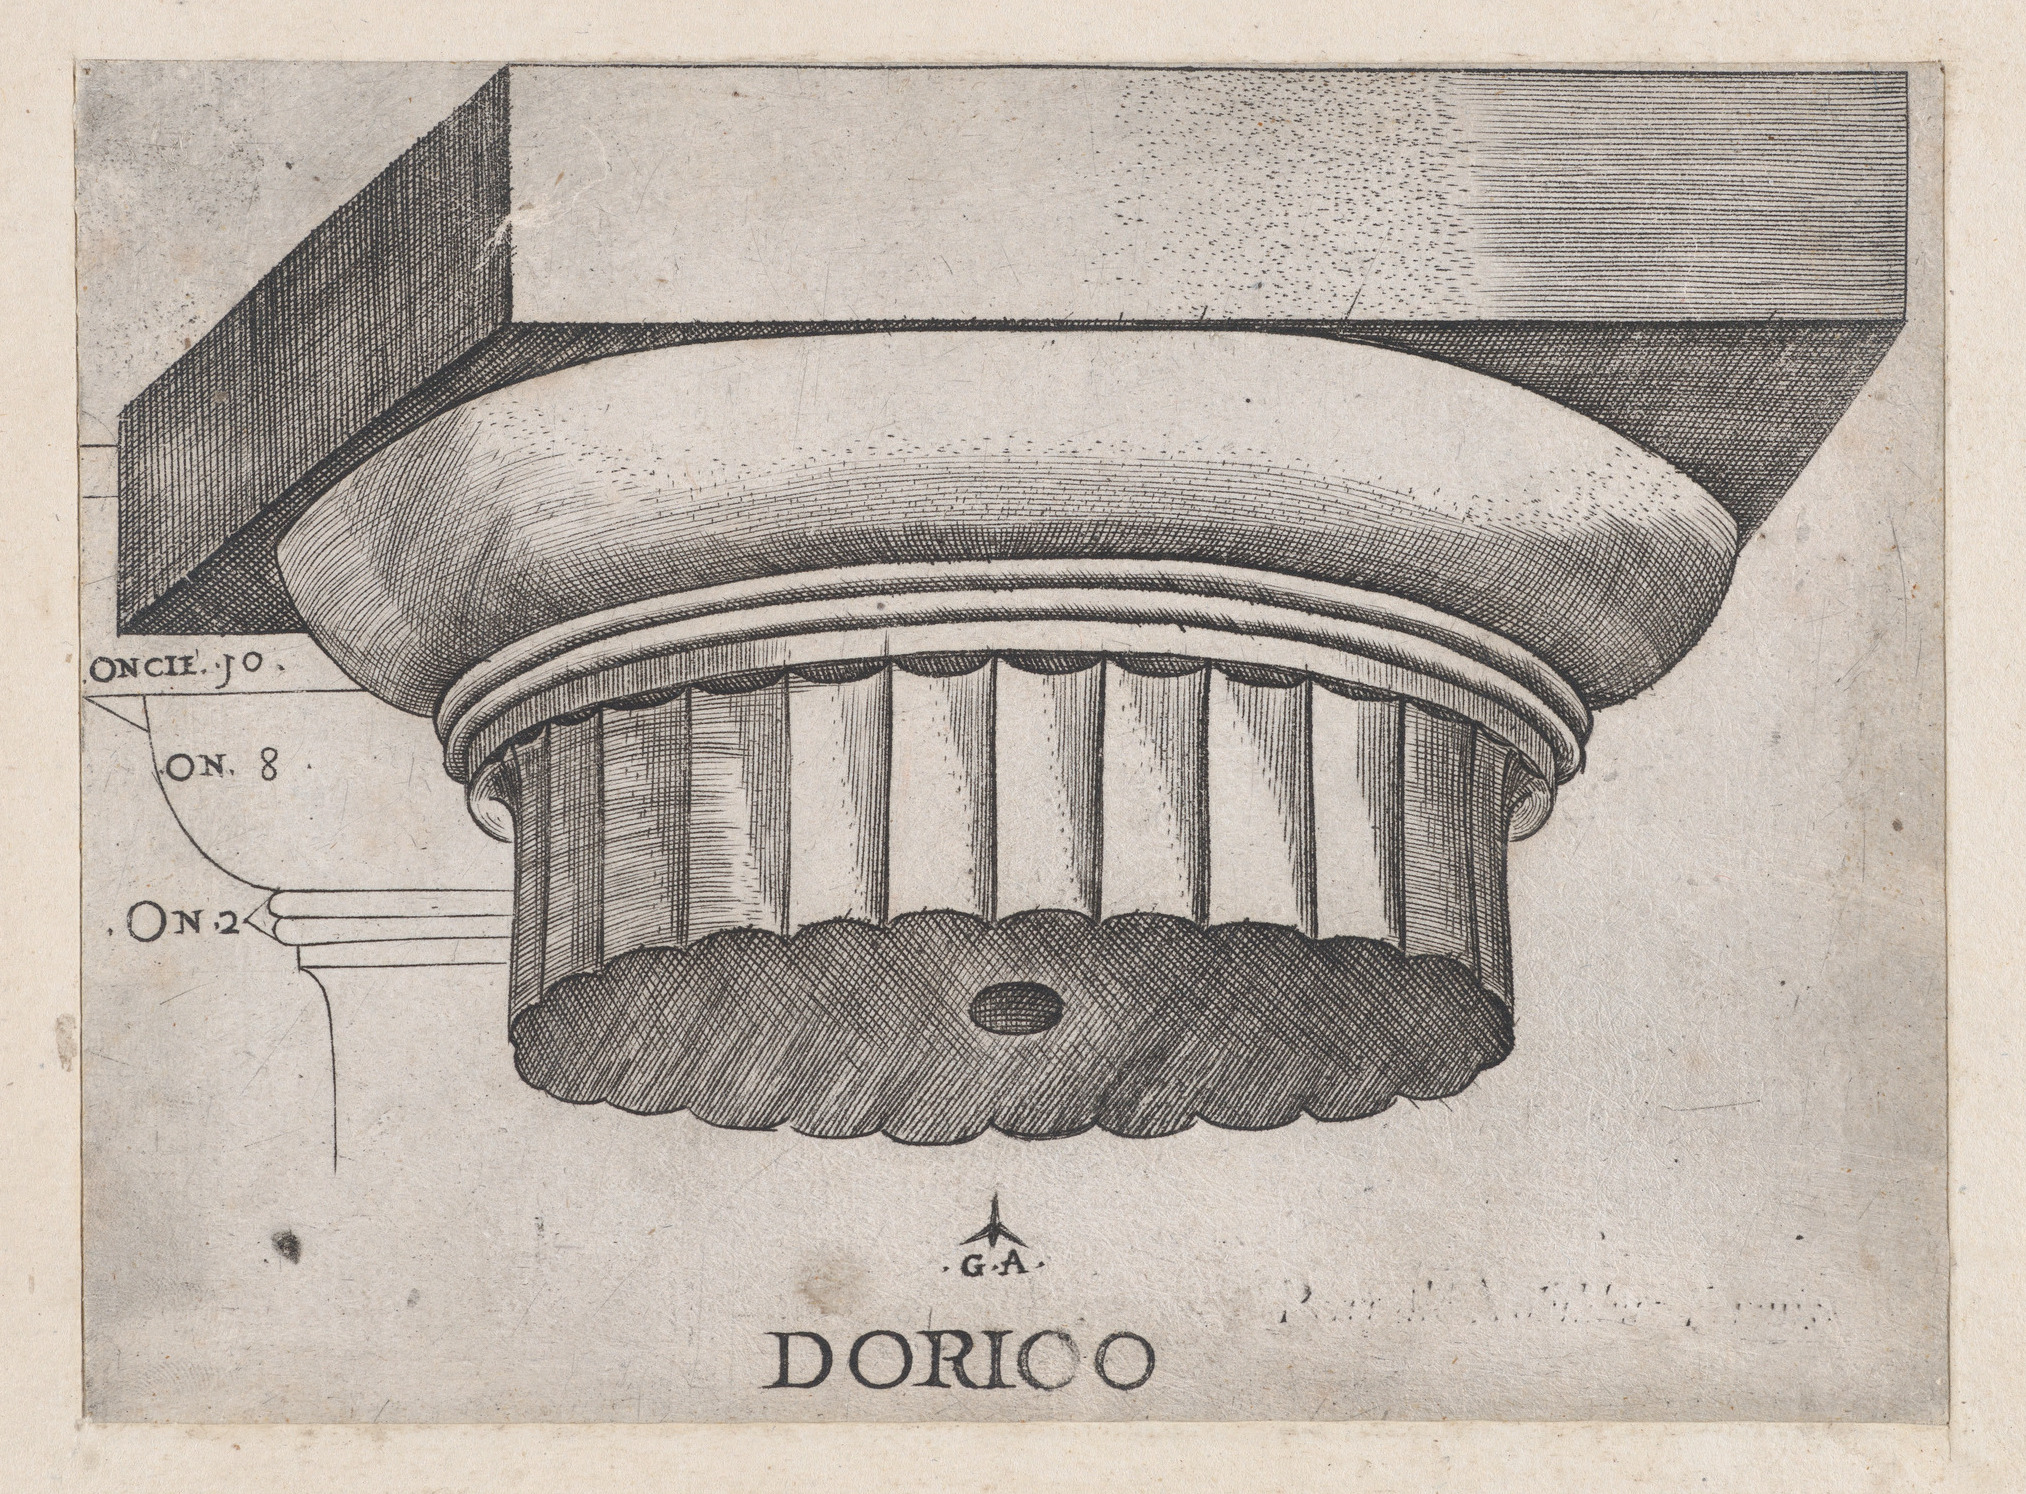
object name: print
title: Doric base, from "Speculum Romanae Magnificentiae"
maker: monogrammist g.a. with the caltrop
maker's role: artist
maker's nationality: italian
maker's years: 1535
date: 1537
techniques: engraving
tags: architecture